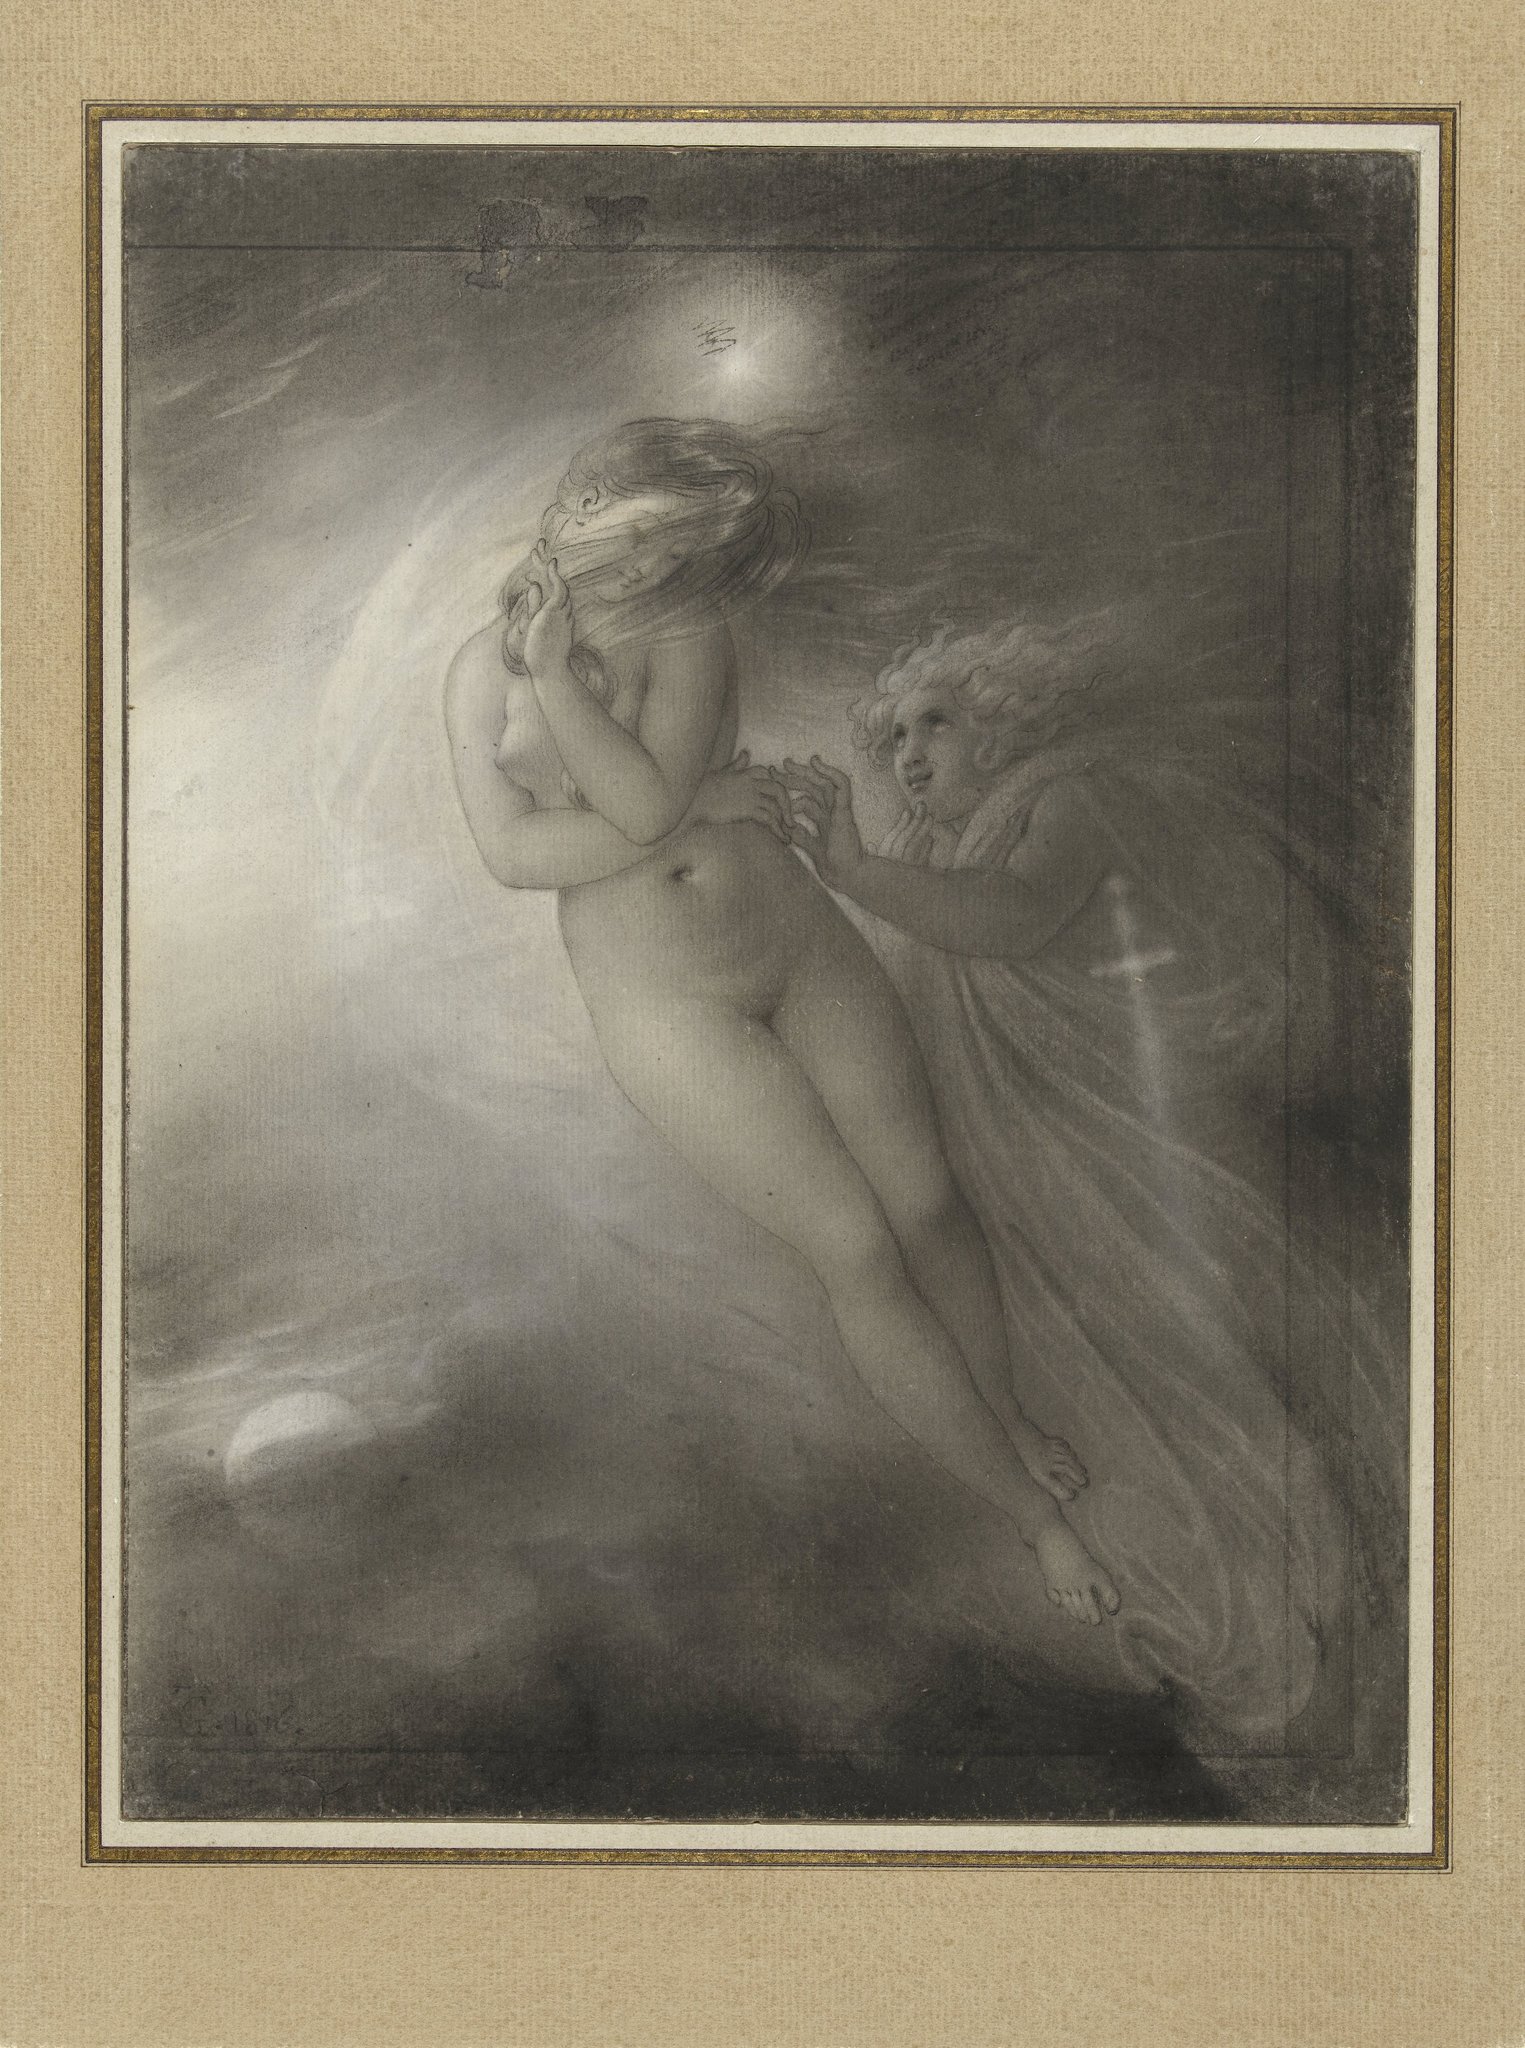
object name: drawing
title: De geesten van Malvina en Oscar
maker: anne-louis girodet-trioson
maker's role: draughtsman, painter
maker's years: 1767-1824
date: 1816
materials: chalk, paper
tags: (scenes from) specific works of literature (with author, title)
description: Episode uit de Ossian: De geesten van Malvina en Oscar.